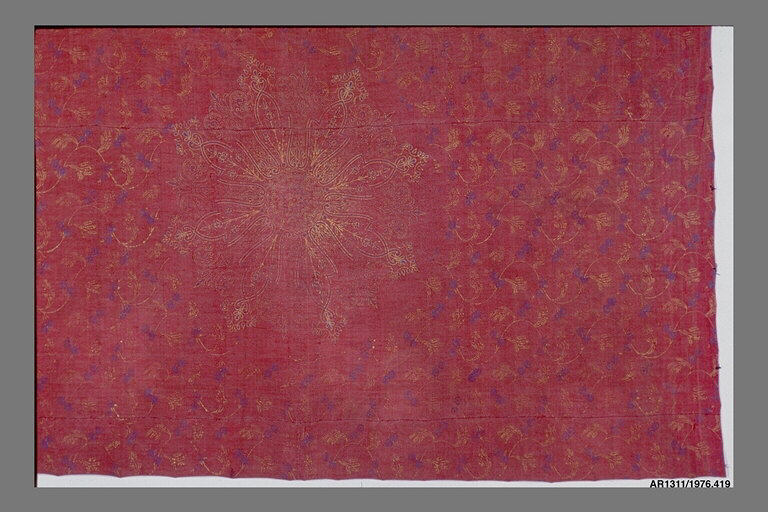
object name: baldachin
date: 1601-1700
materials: silk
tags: flowers